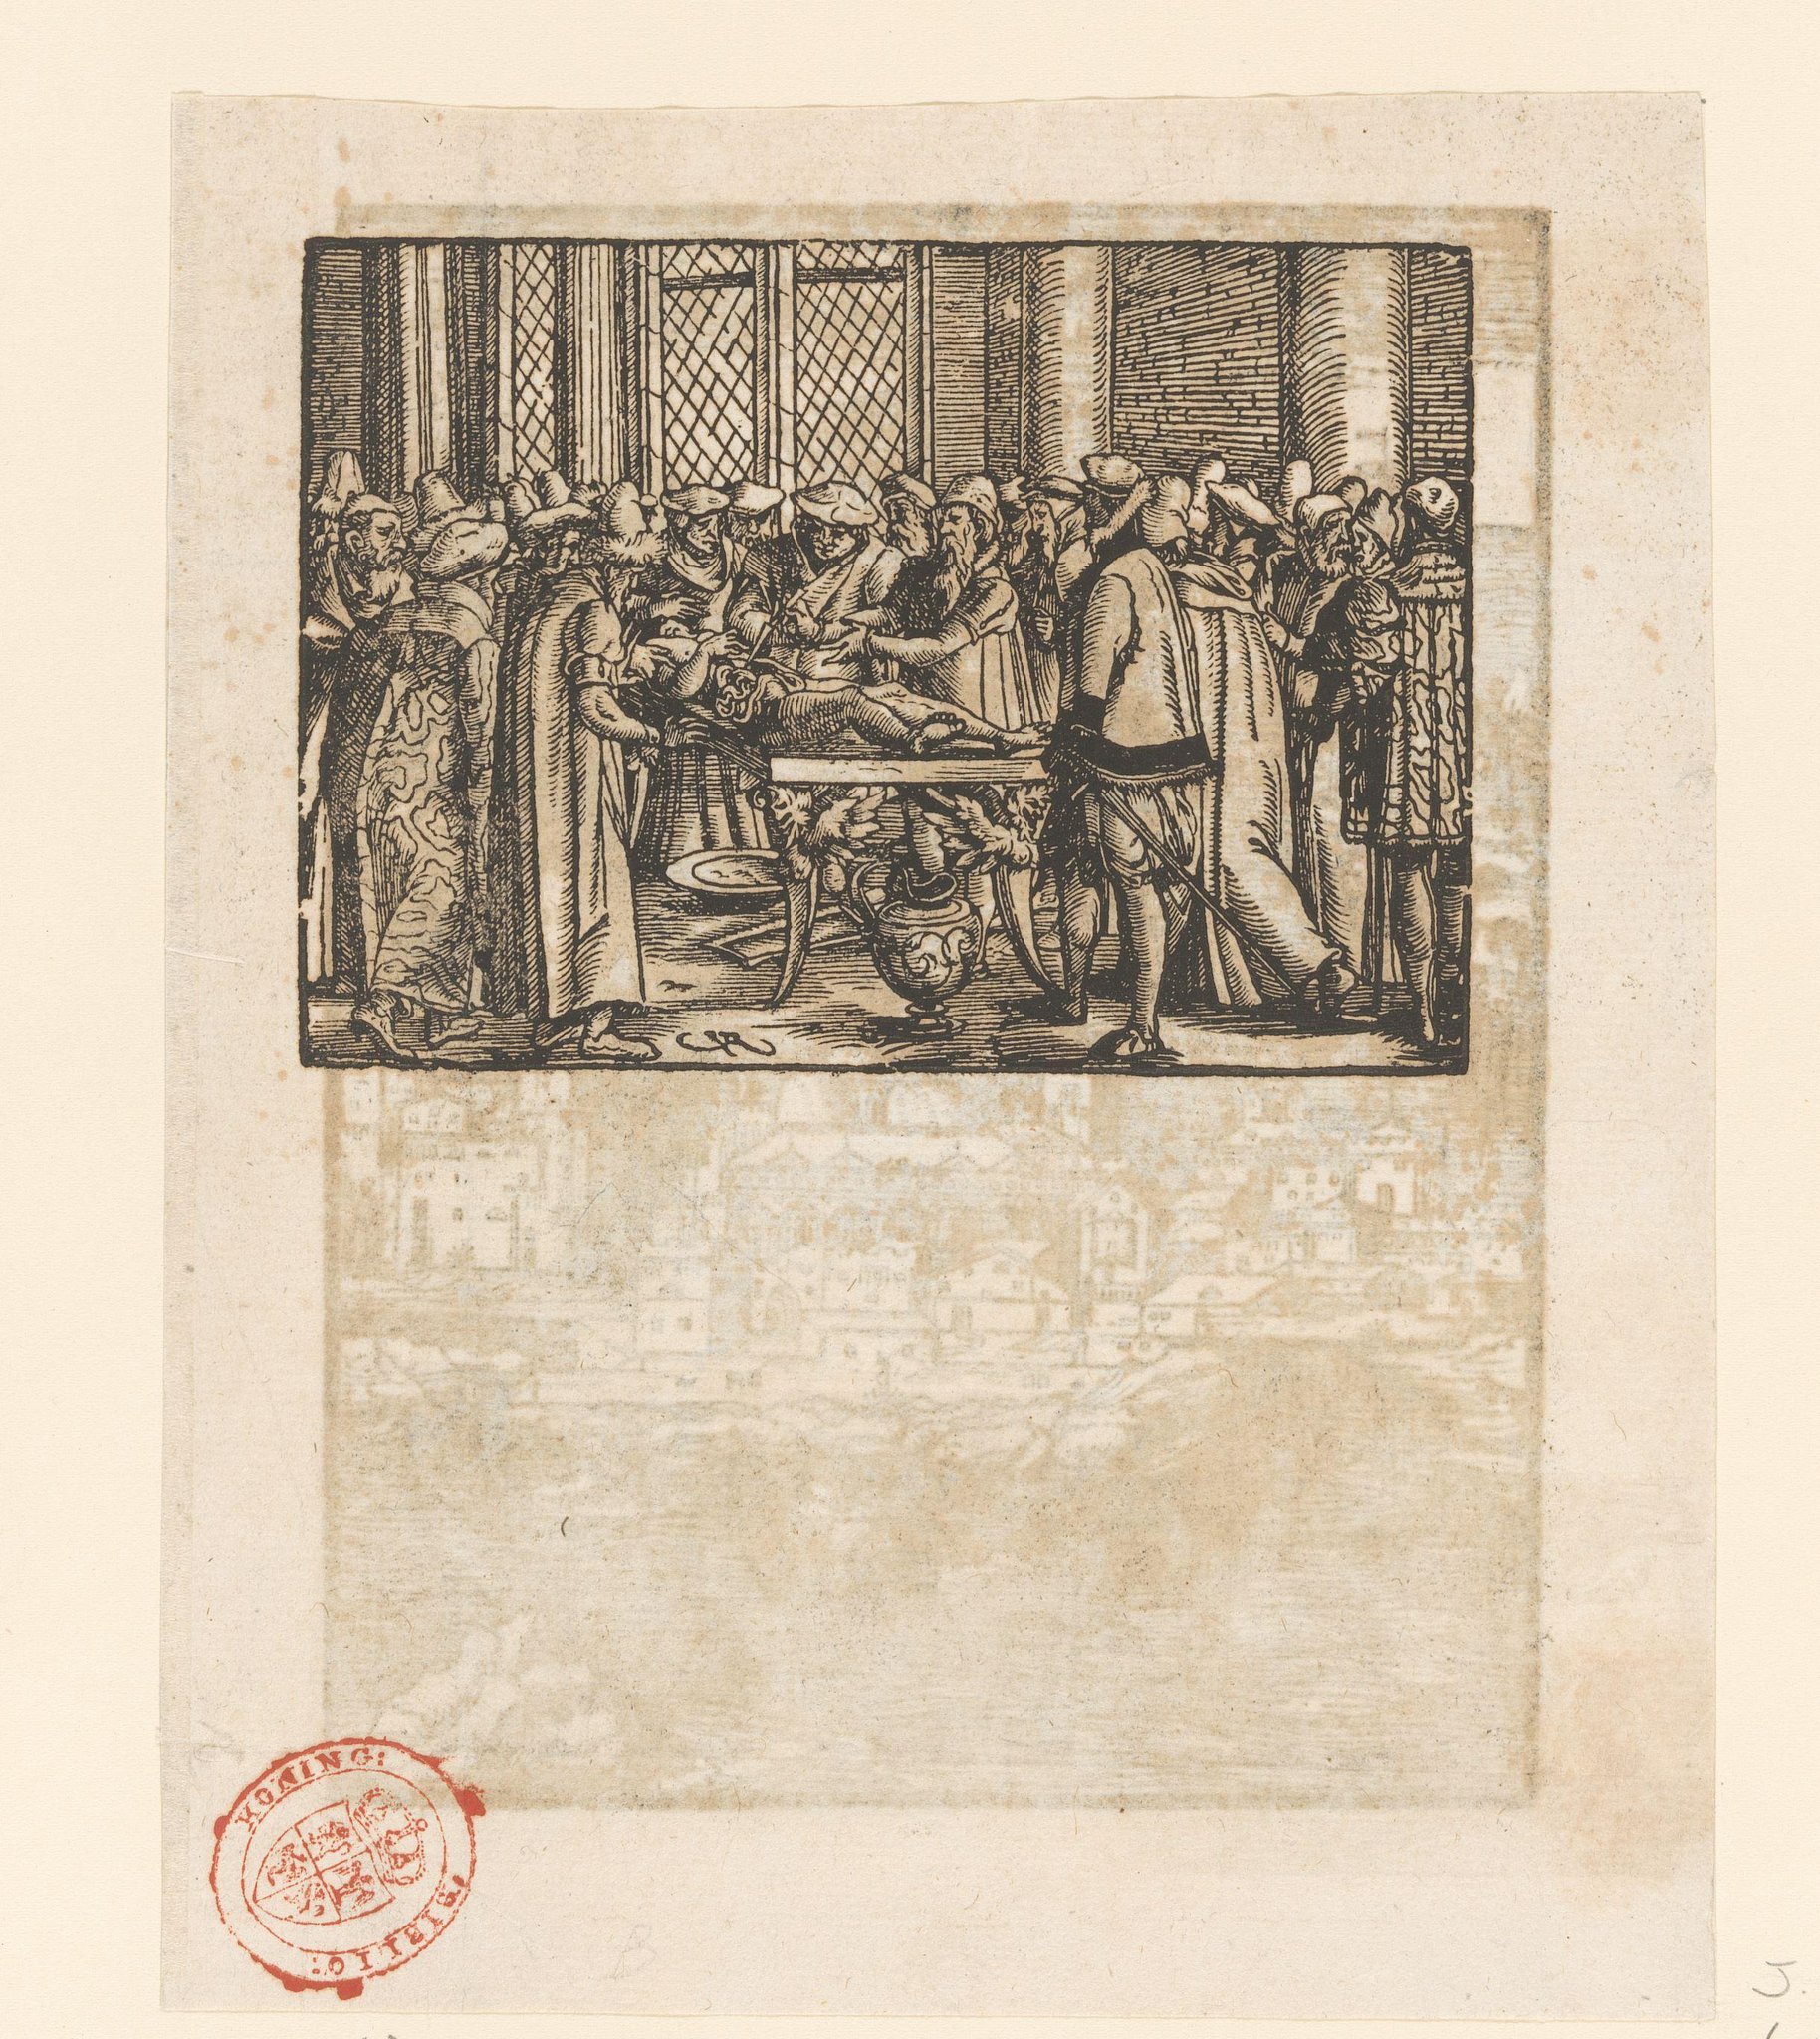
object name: book illustration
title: Anatomische les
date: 1600-1699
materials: paper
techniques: woodcut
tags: anatomy lesson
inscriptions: collector's mark: Lugt 240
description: Prent afkomstig uit: Paracelsus, Theophrastus. Opvs Chyrvrgicvm. Frankfurt am Main: Feyeravend, 1566.